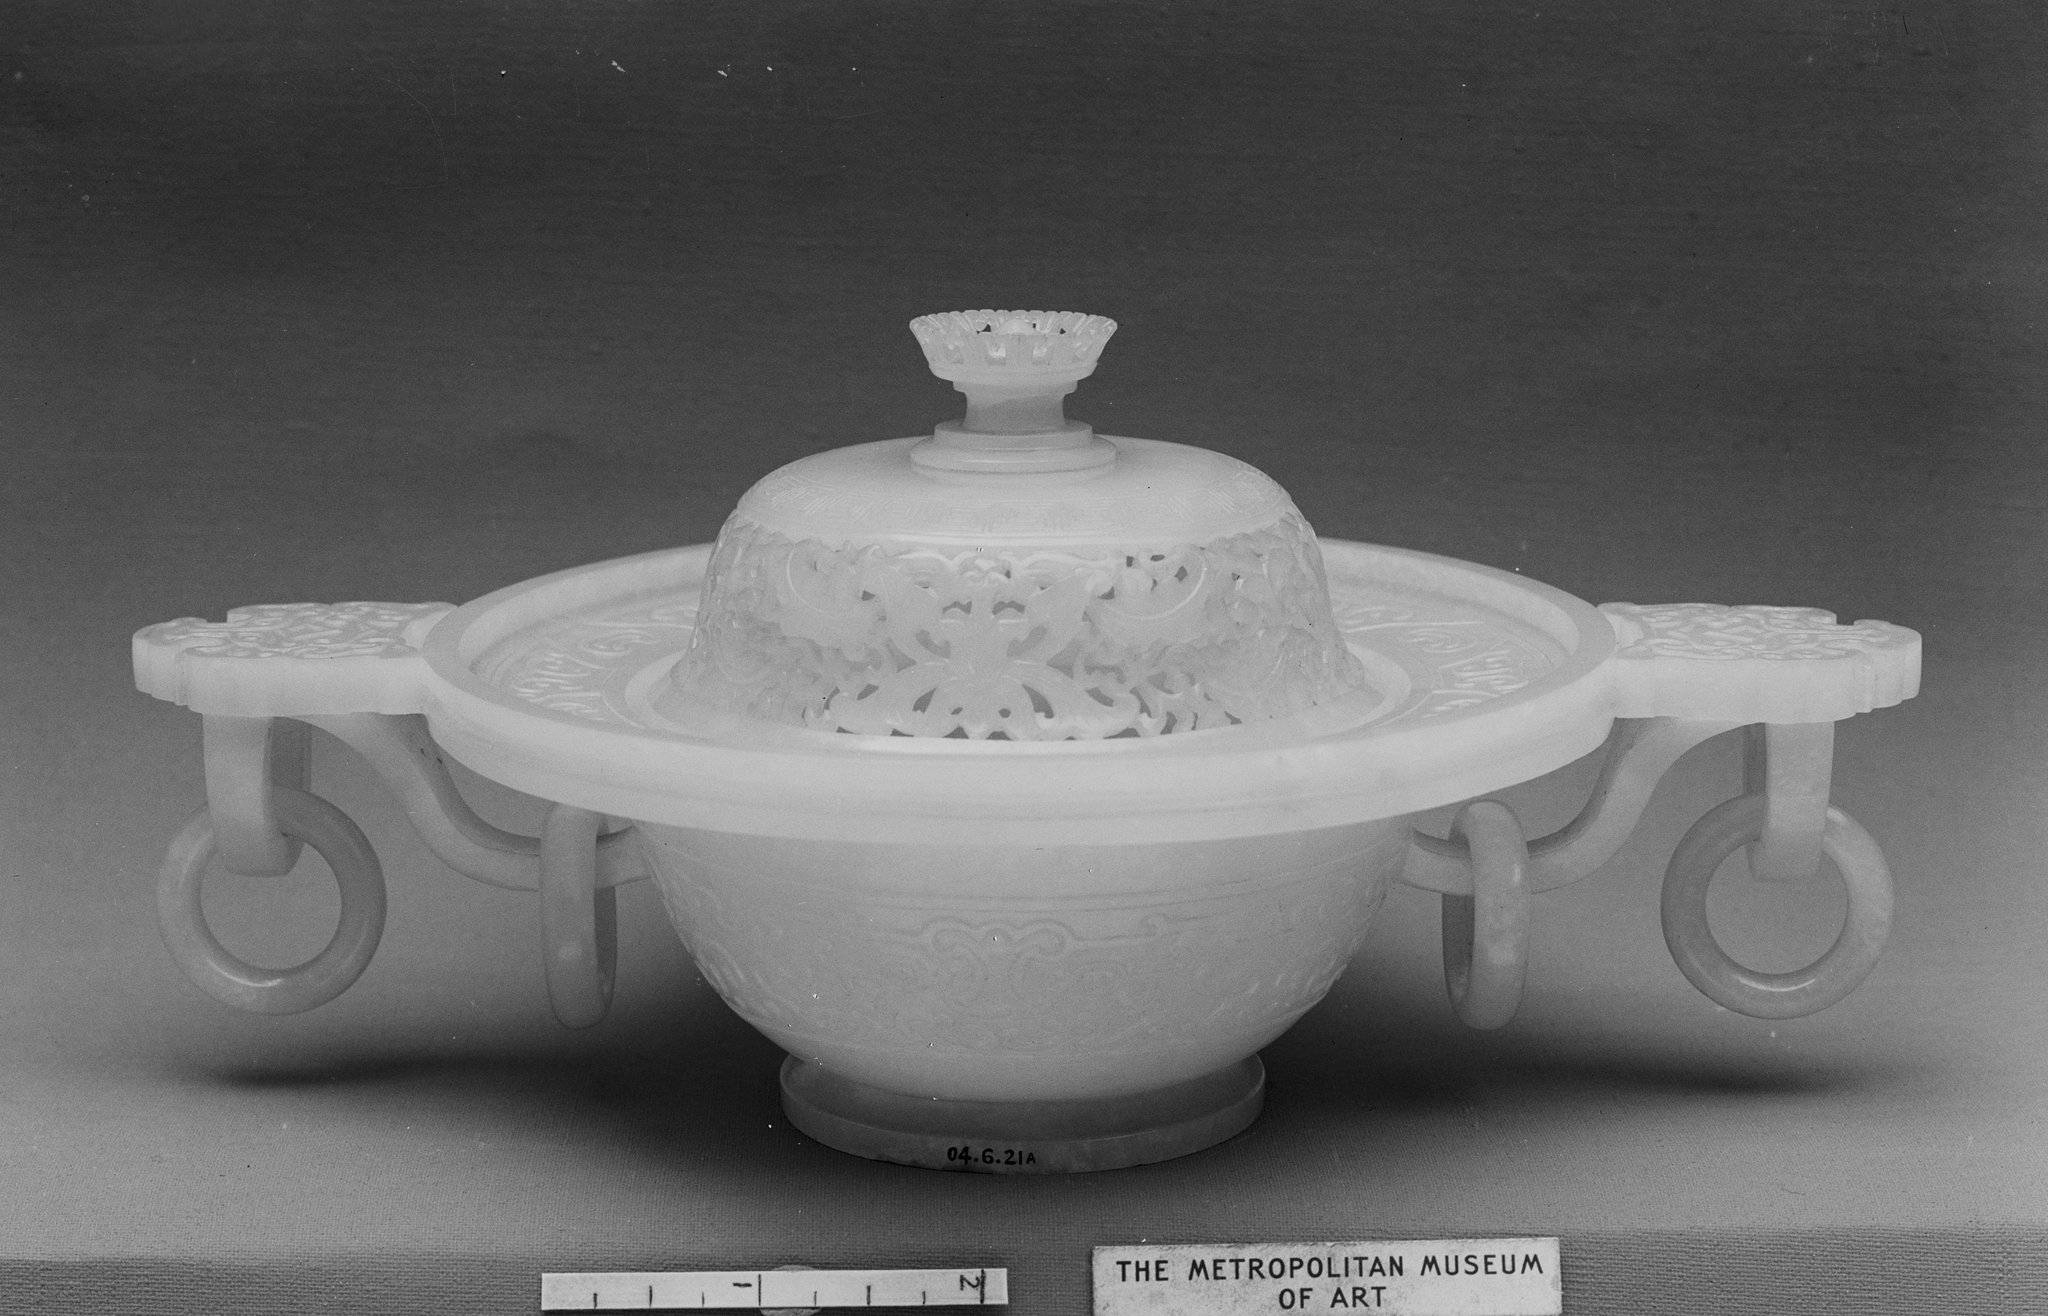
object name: covered bowl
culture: chinese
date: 1736-1795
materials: jade